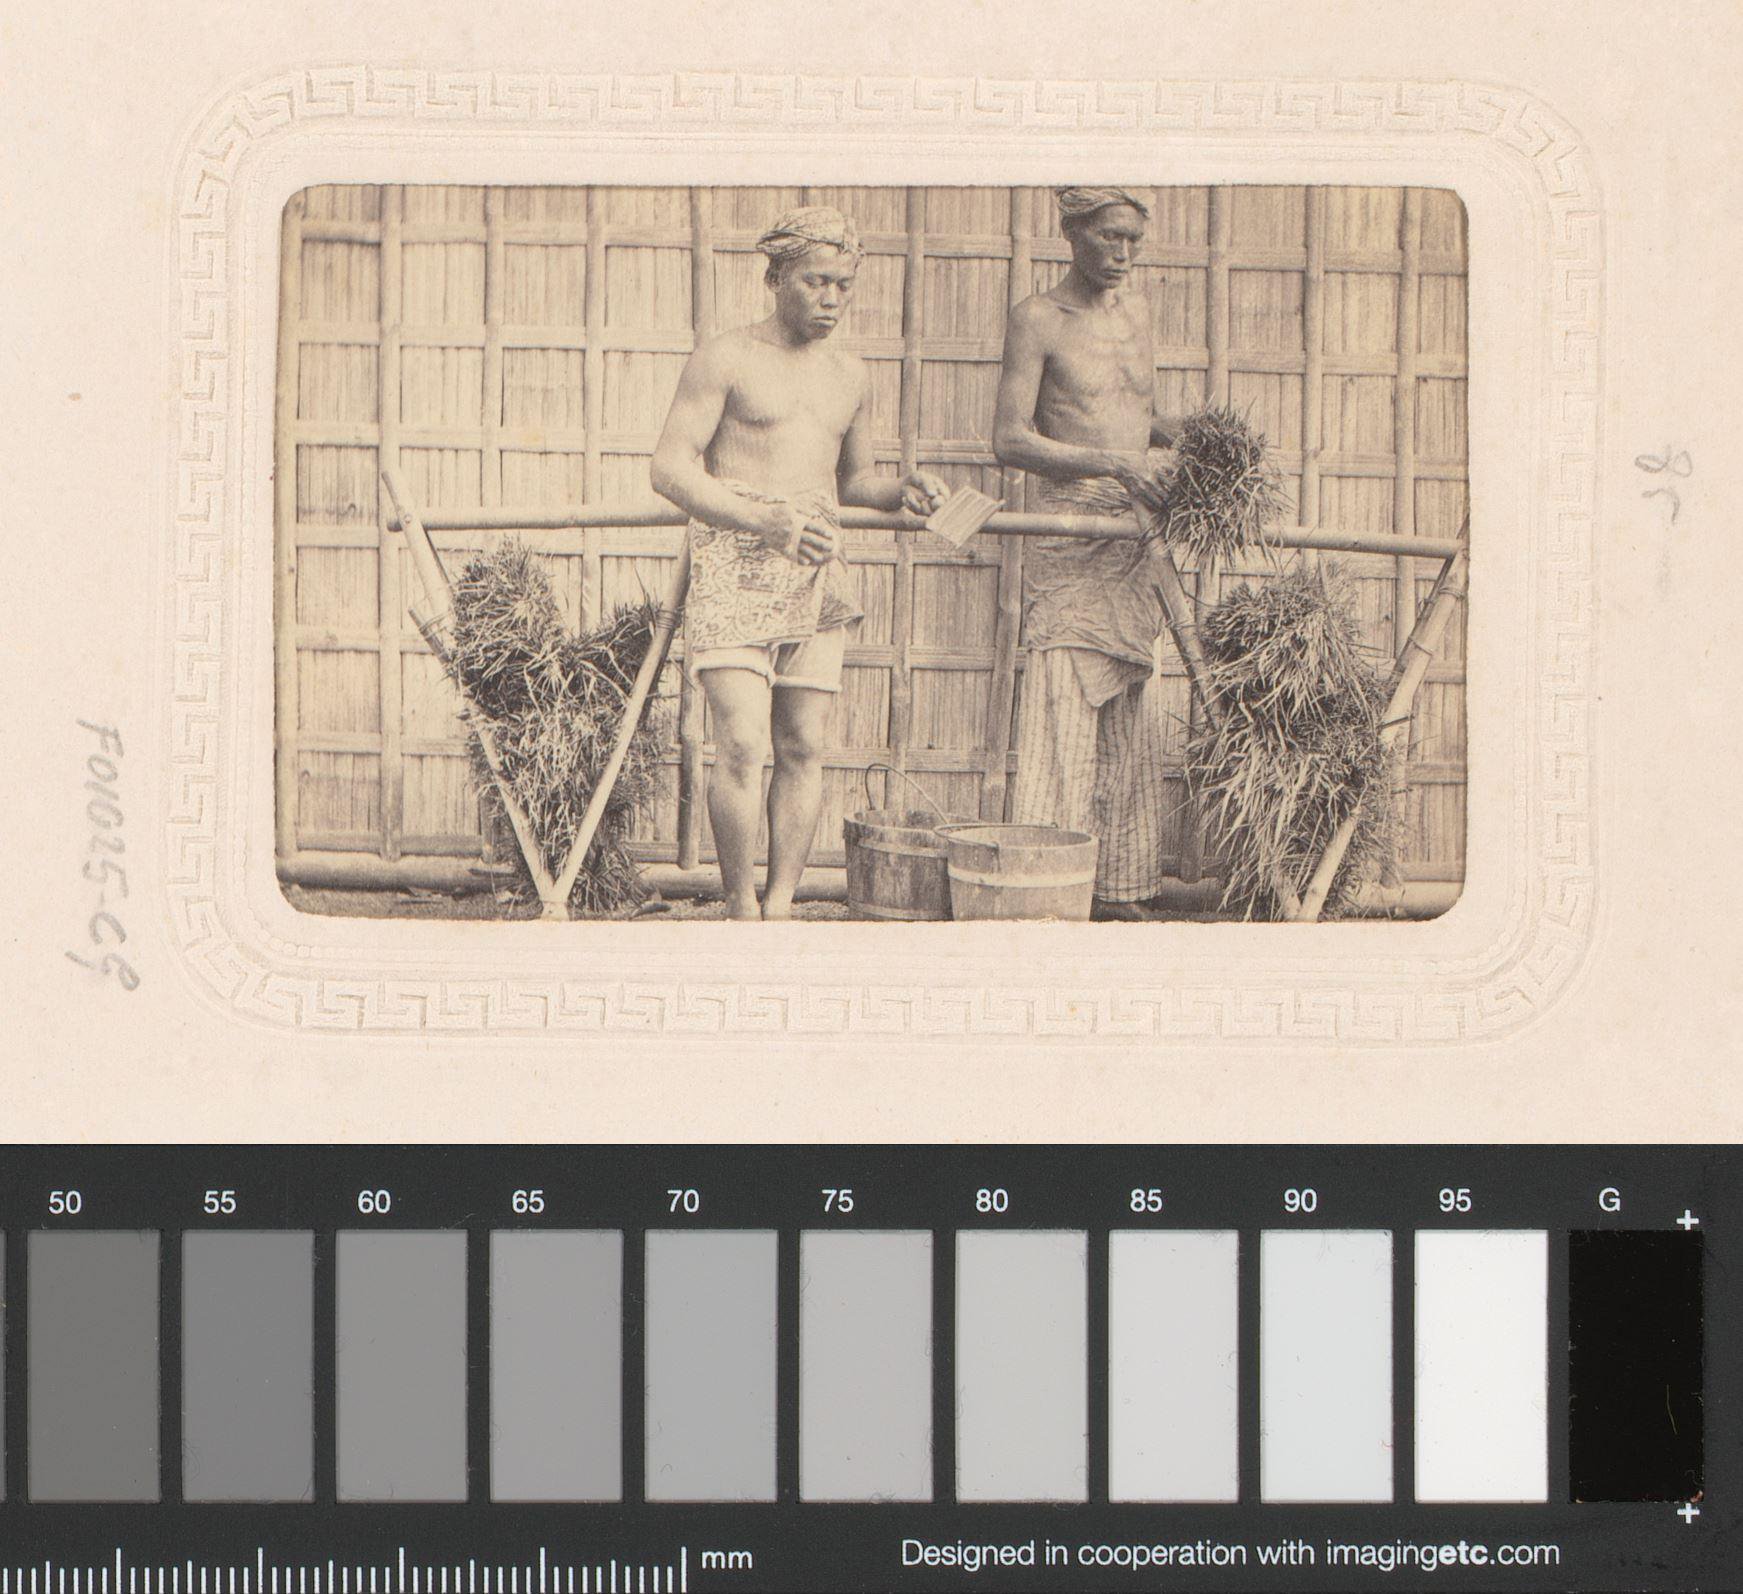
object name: photograph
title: Twee arbeiders te Indonesië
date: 1857-1880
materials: cardboard, photographic support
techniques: albumen print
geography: indonesia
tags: working class, labourers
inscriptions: inscription: ‘Woodbury & Page/ Photographers/ Java’, number: ‘85’